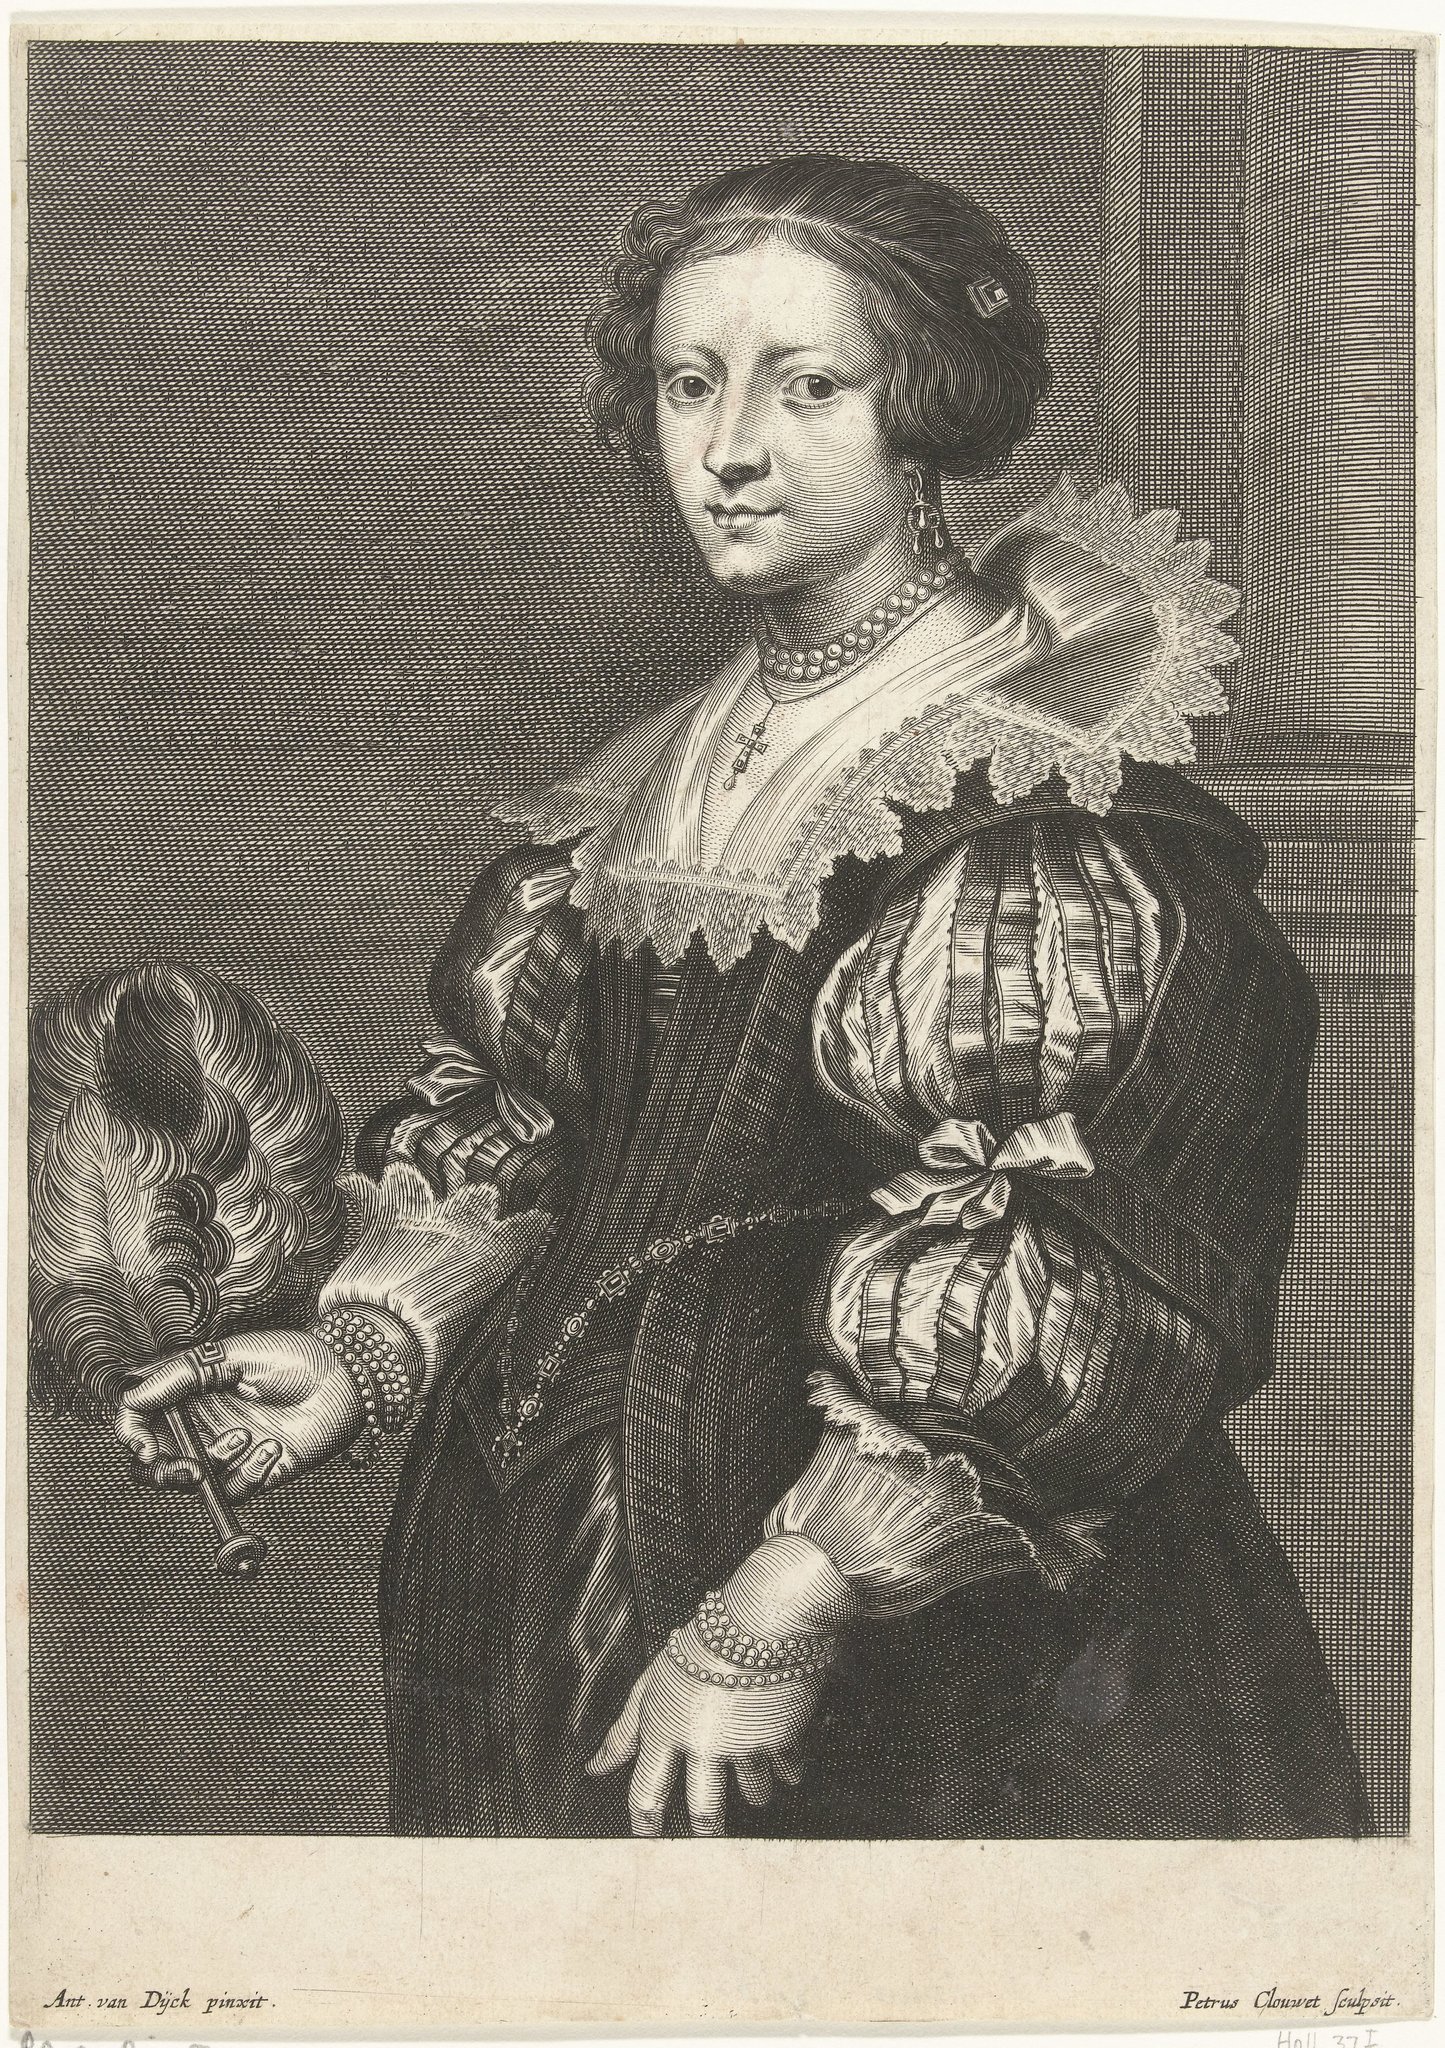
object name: print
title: Portret van Anna Wake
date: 1639-1670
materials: paper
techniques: engraving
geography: antwerp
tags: anna wake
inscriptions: collector's mark: Lugt 240, caption: ‘D. Anna Wake’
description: Portret van Anna Wake, de vrouw van de Antwerpse koopman Peeter Stevens. Buste naar links. Anna Wake is rijkelijk gekleed en heeft een waaier in de rechterhand.